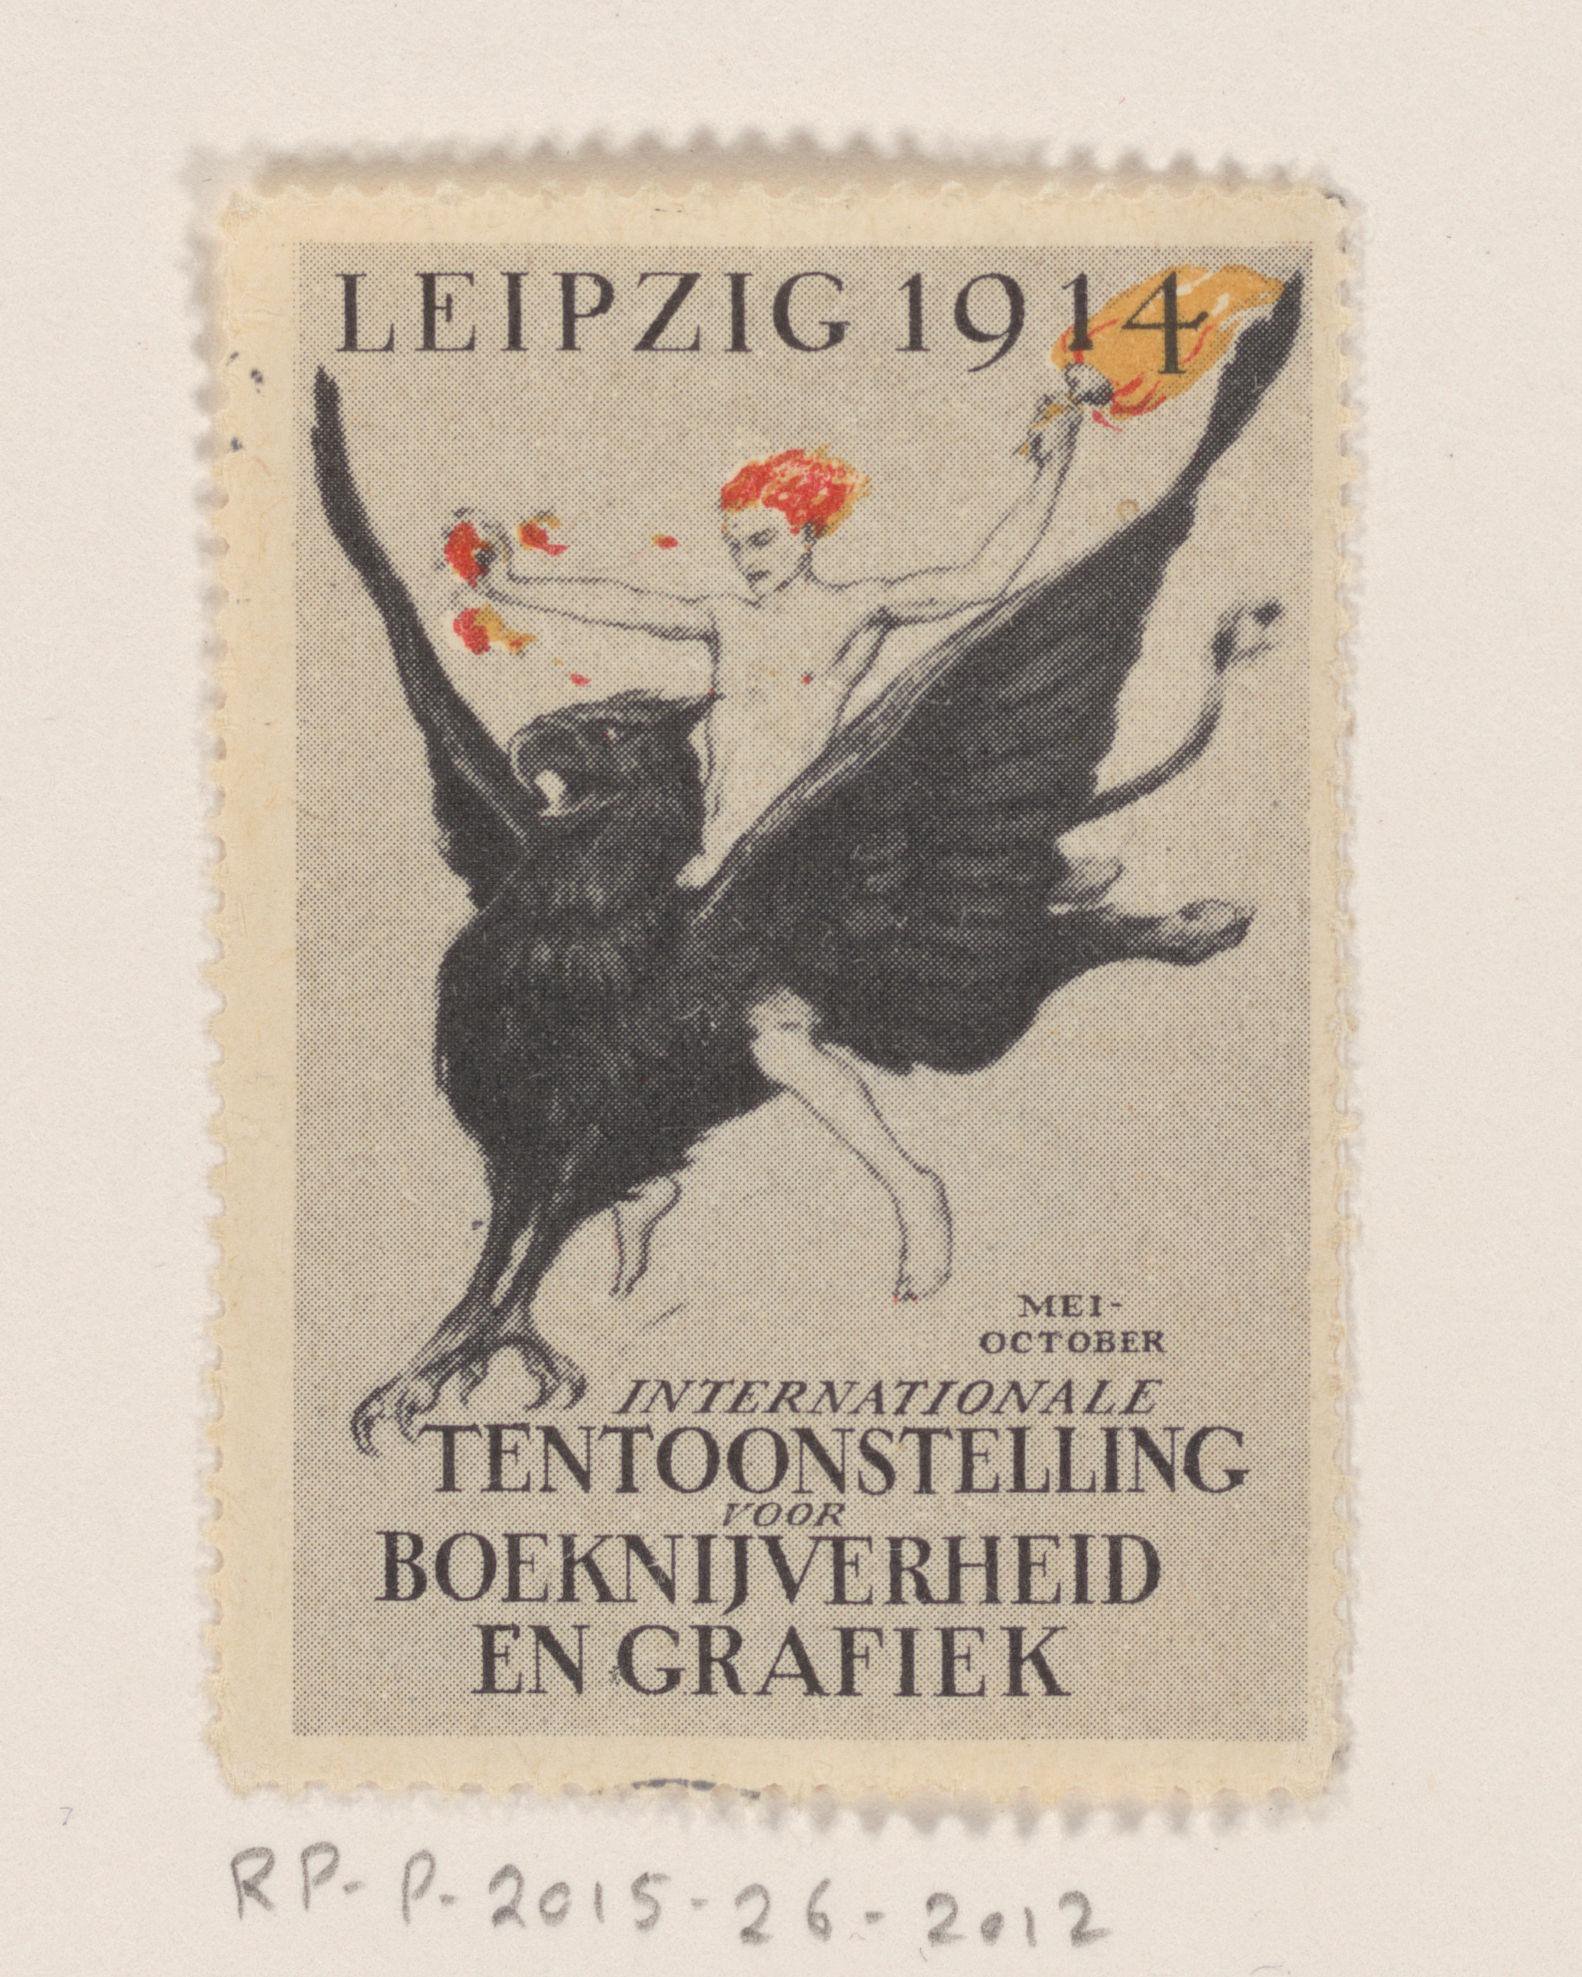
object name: postage stamp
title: Genius rijdend op een Griffioen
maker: Anonymous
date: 1914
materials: paper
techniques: photochemical processes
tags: griffin (lion/eagle); 'griffo' (ripa), world fair, world exhibition, 'genio' (ripa)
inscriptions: collector's mark: Lugt 2228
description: Postzegel uitgegeven ter gelegenheid van de Internationale Tentoonstelling voor Boeknijverheid en Grafiek (Internationale Ausstellung für Buchgewerbe und Graphik) gehouden te Leipzig in 1914.